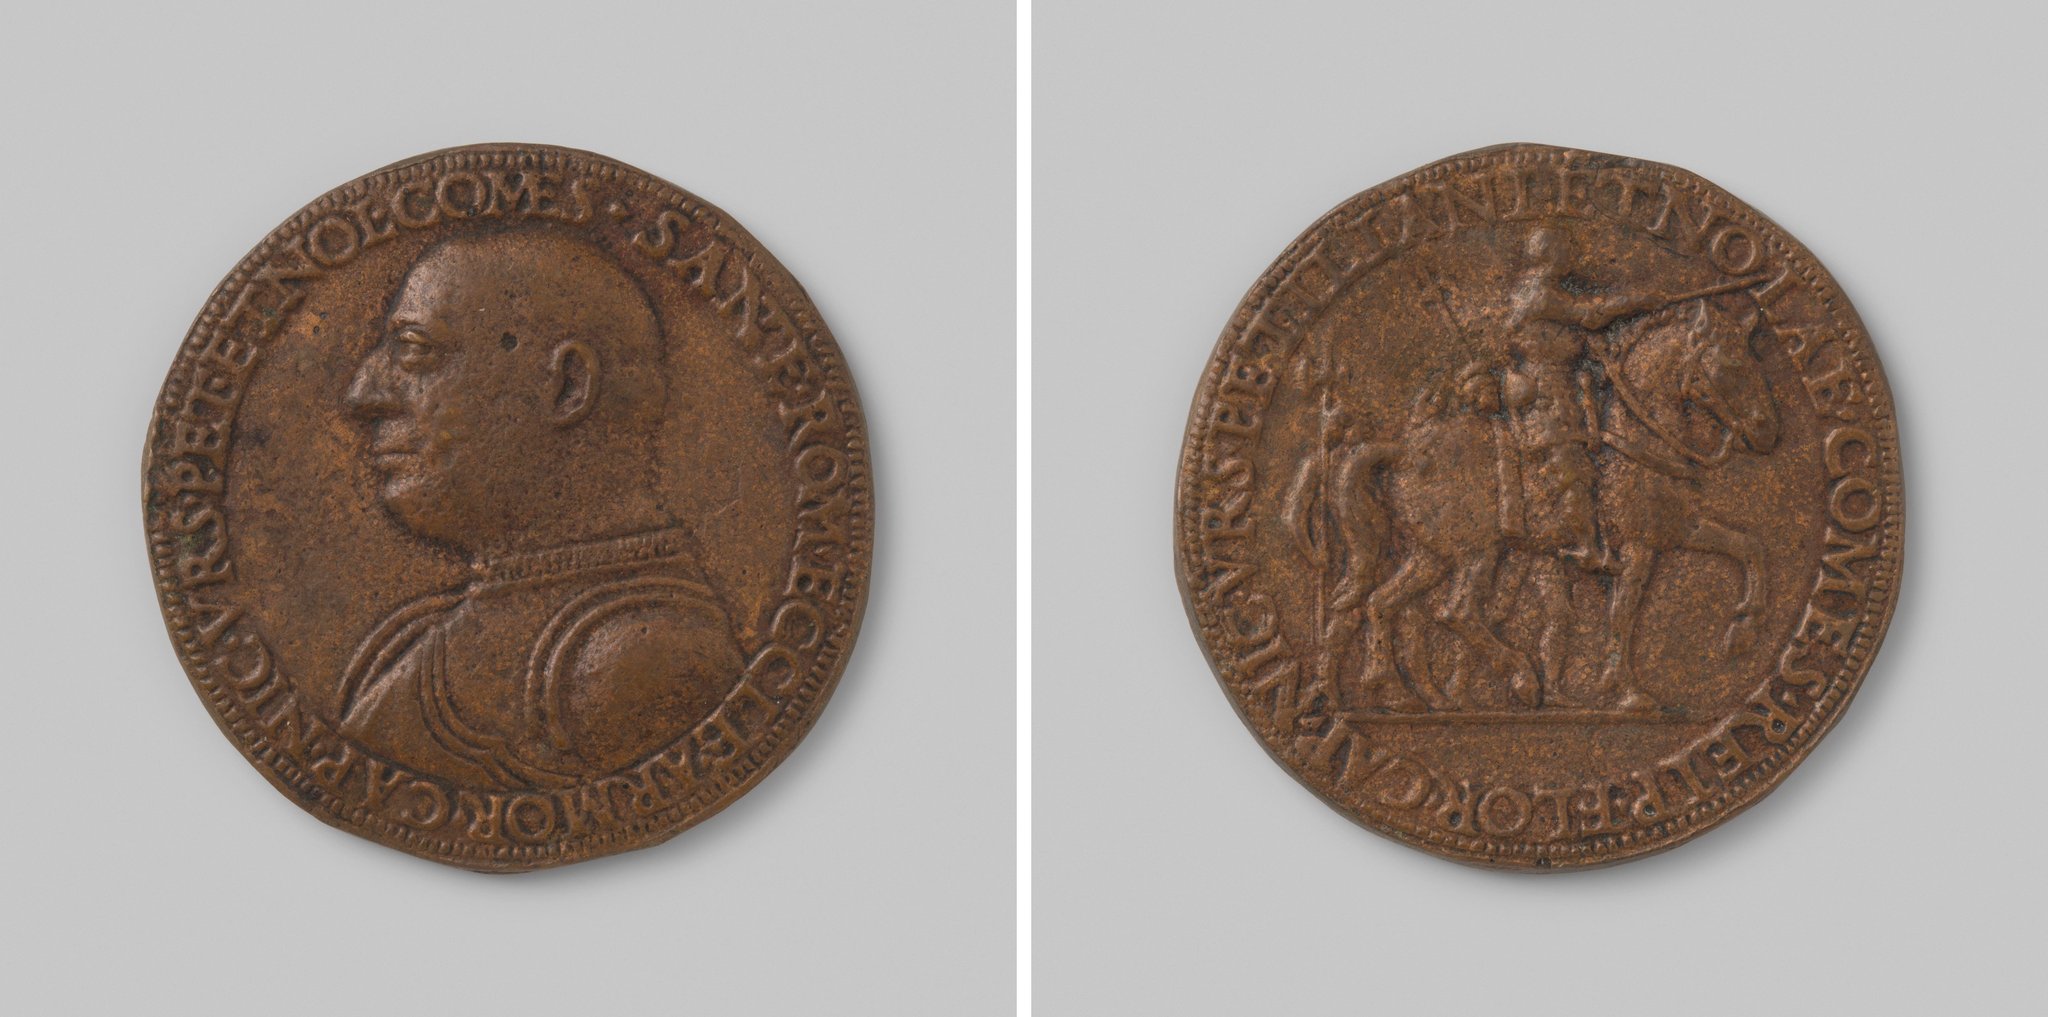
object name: history medal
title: Niccolo Ursini, graaf van Pitigliano en Nola, benoemd tot veldheer van Venetië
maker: Anonymous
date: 1509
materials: bronze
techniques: casting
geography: italy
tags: niccolo ursini (graaf van pitigliano-nola)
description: Bronzen penning. Voorzijde: borststuk man binnen omschrift. Keerzijde: veldheer te paard met commandostaf; achter hem soldaten met lansen binnen omschrift